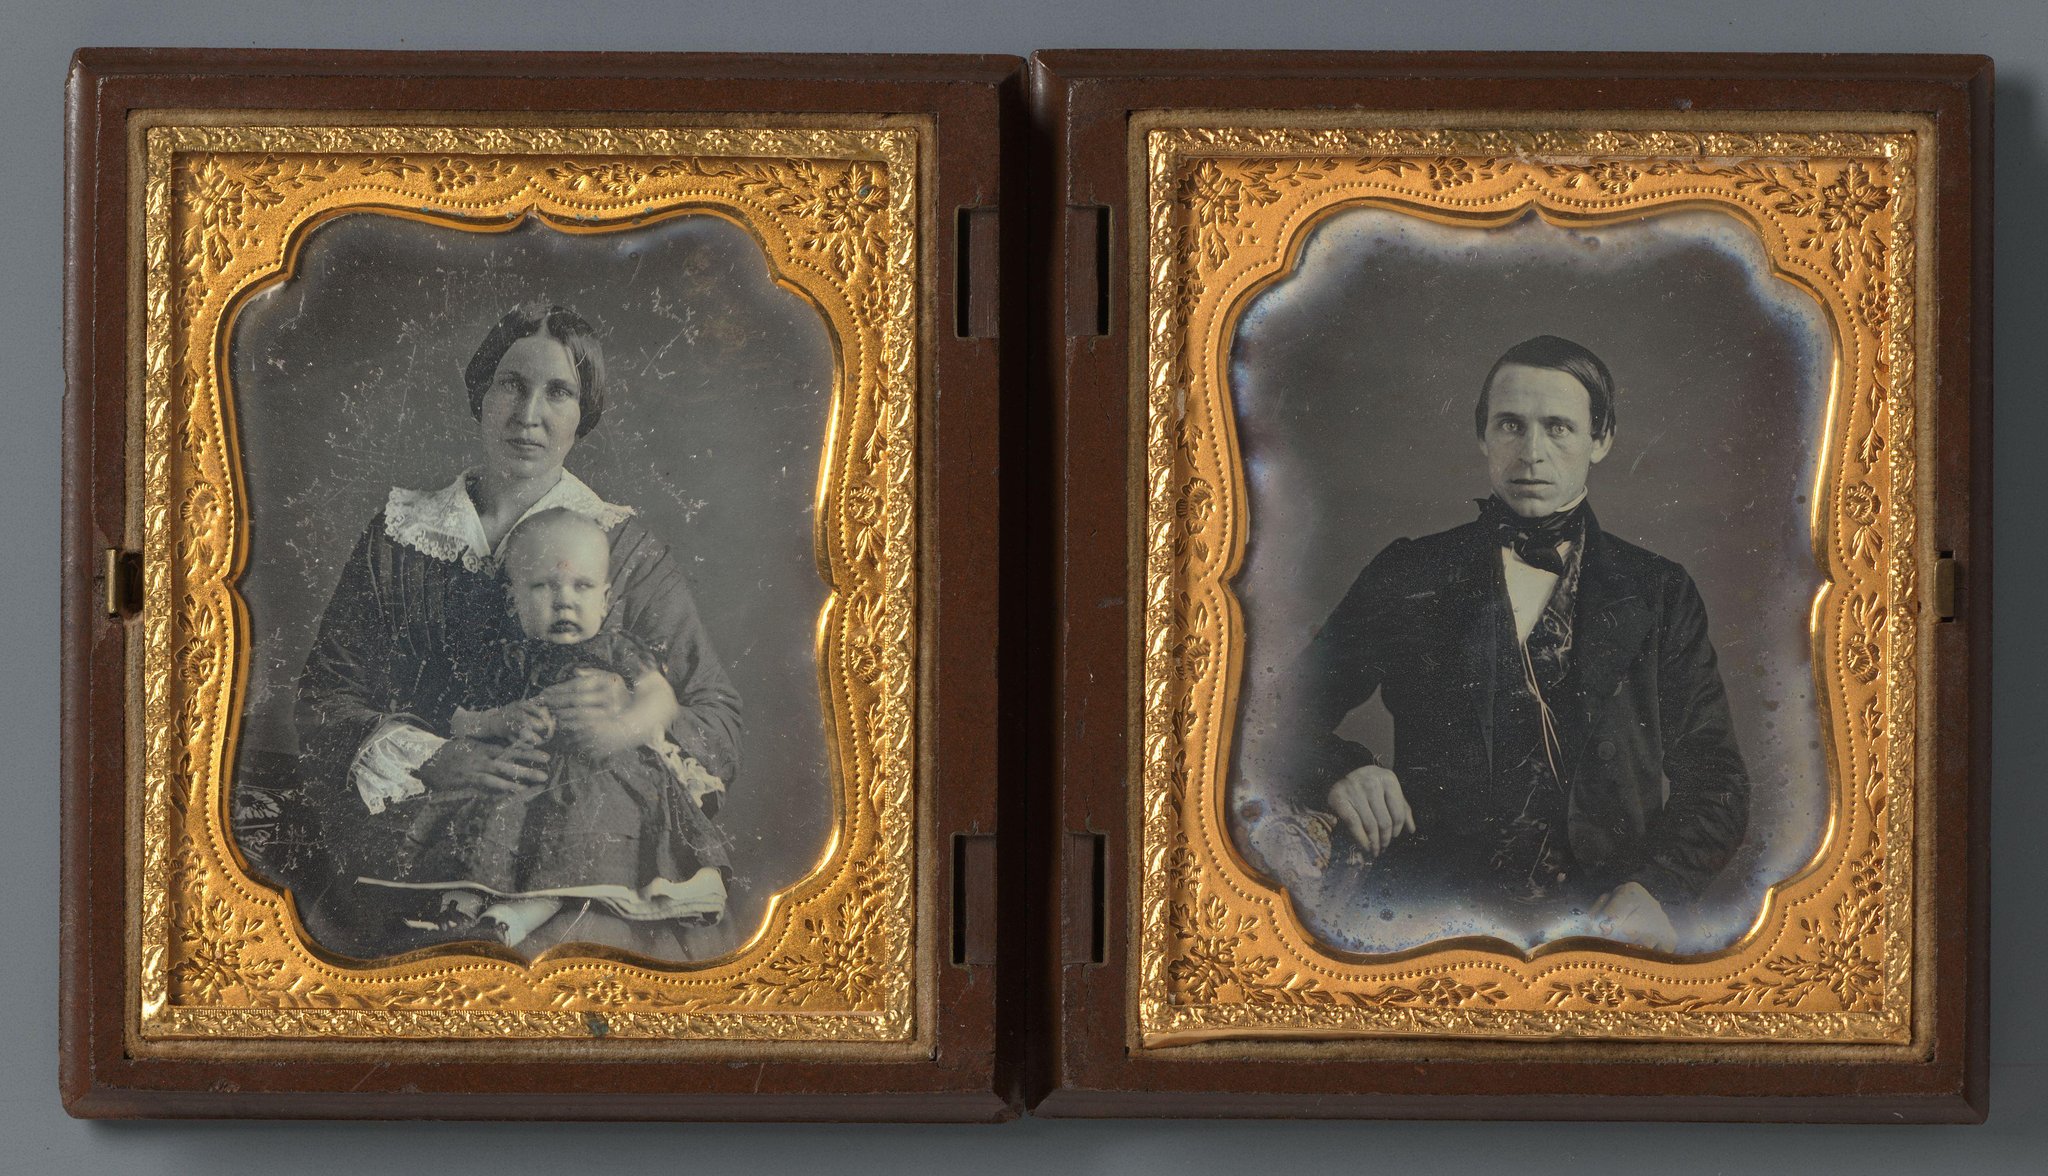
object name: photograph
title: Portret van een onbekende vrouw met kind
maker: Anonymous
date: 1858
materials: copper, glass, plastic, velvet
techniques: daguerreotype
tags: toddler, adult woman, historical persons